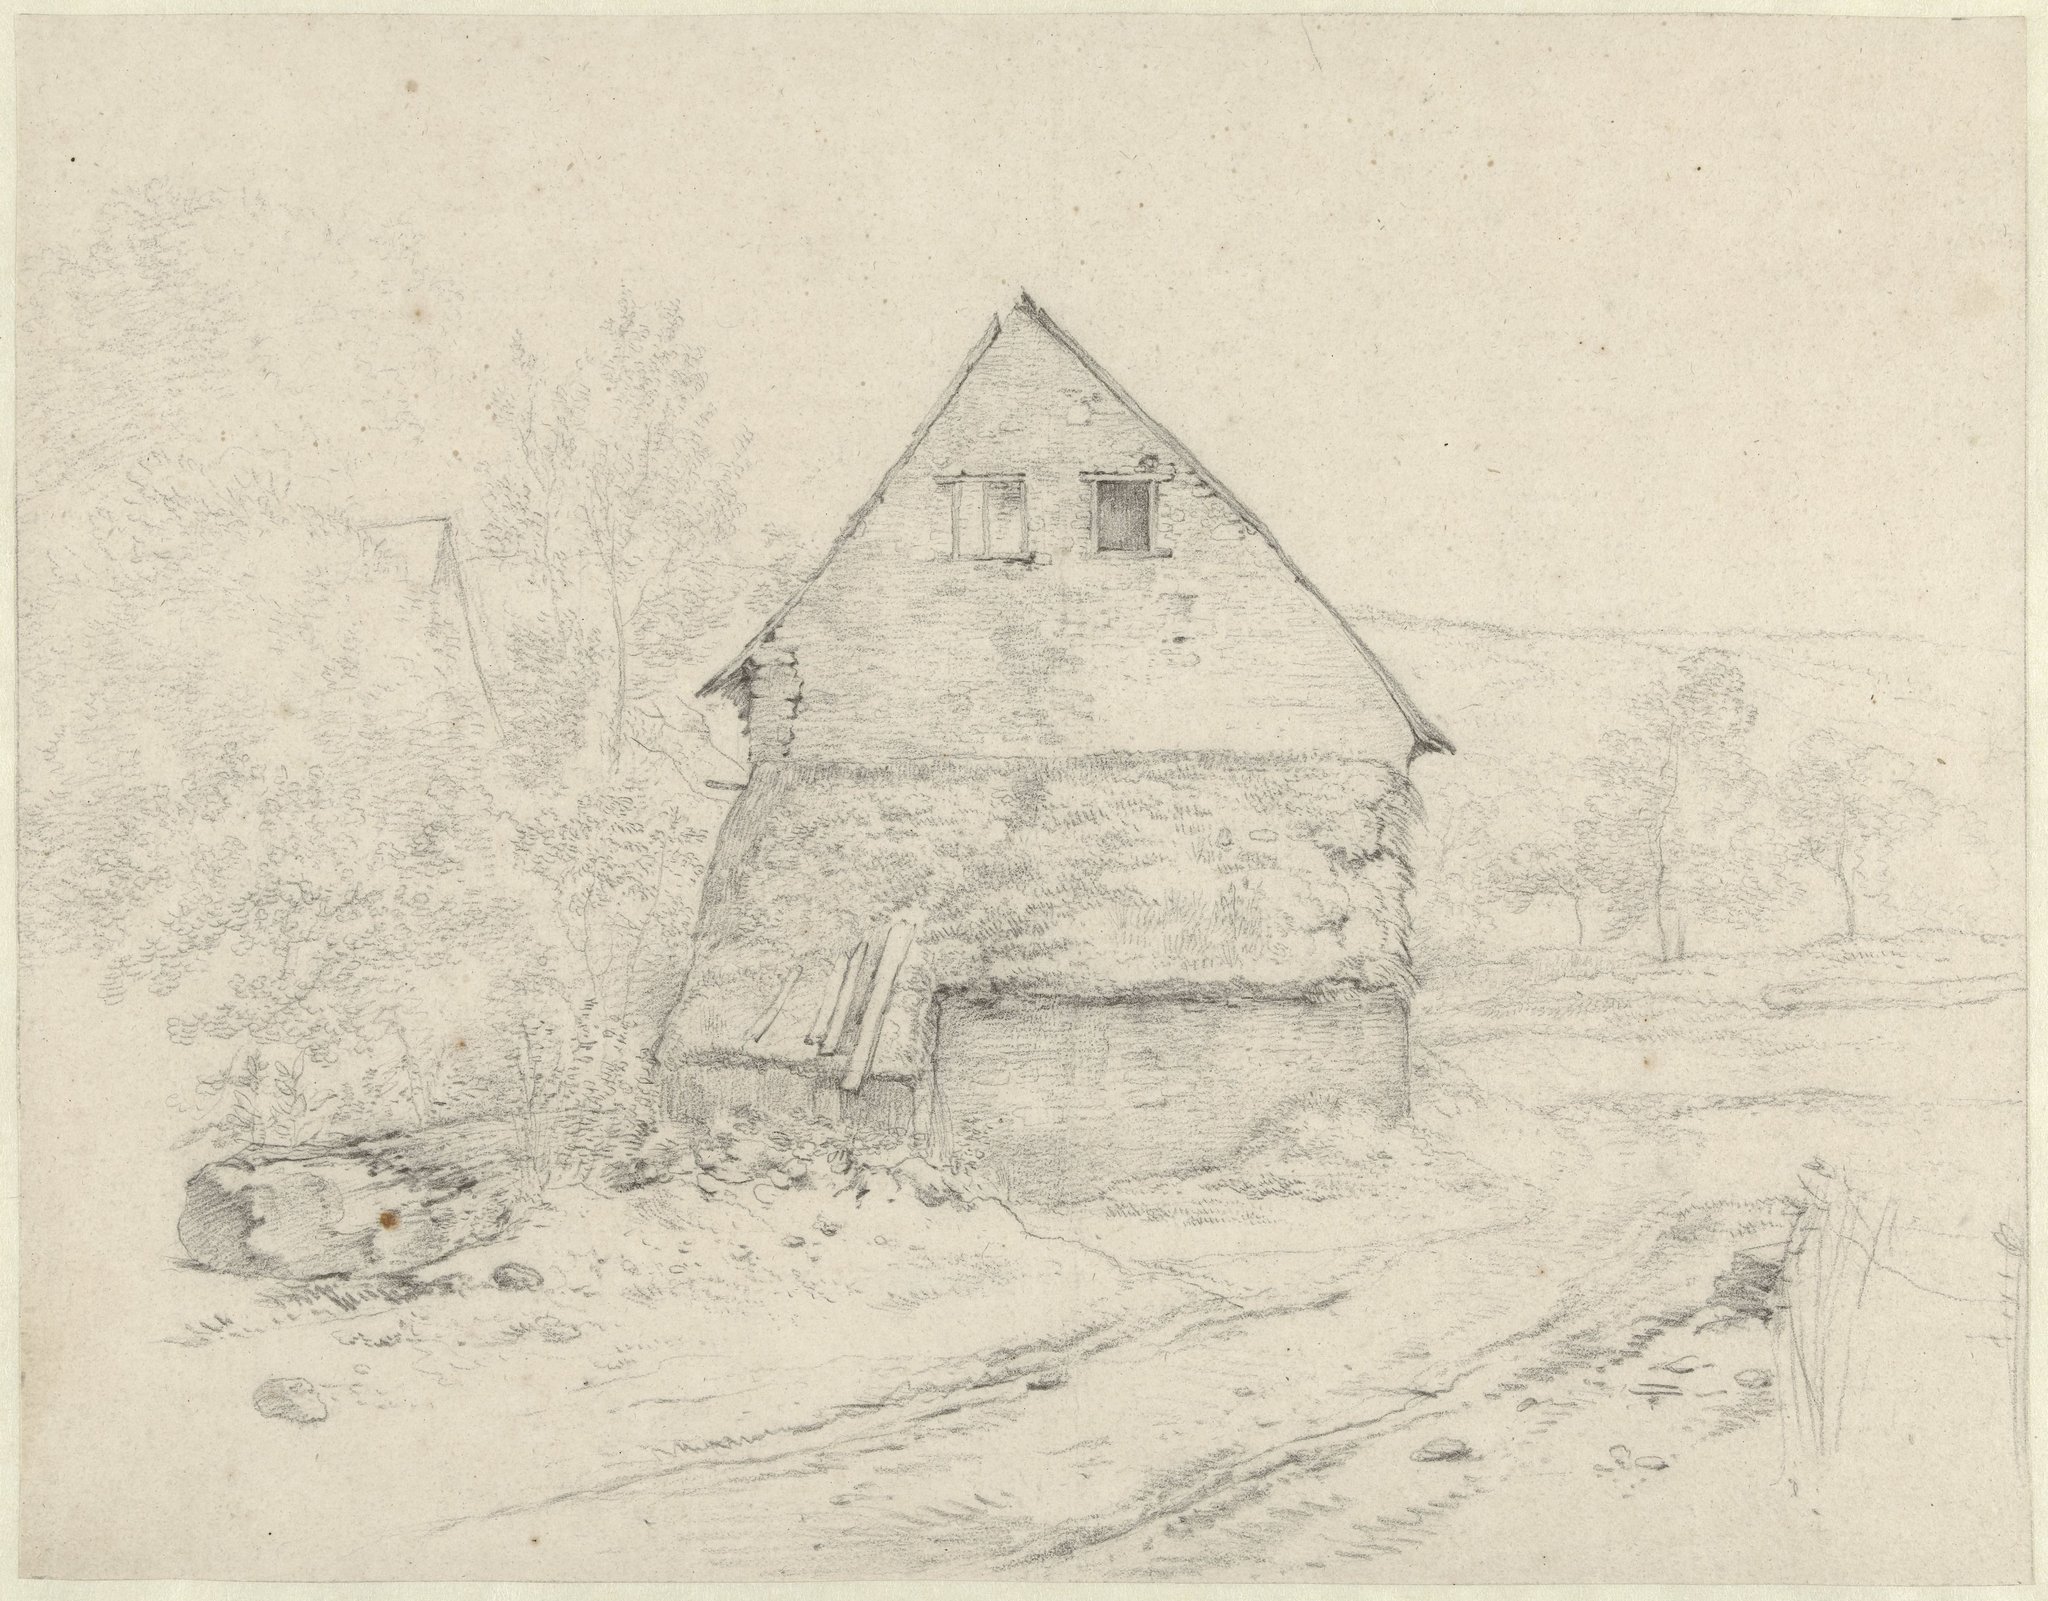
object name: drawing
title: Huis aan een weg in een heuvellandschap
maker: abraham johannes ruytenschildt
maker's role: draughtsman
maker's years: 1778-1841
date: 1788-1841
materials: chalk, paper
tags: landscapes, road, path, farm or solitary house in landscape